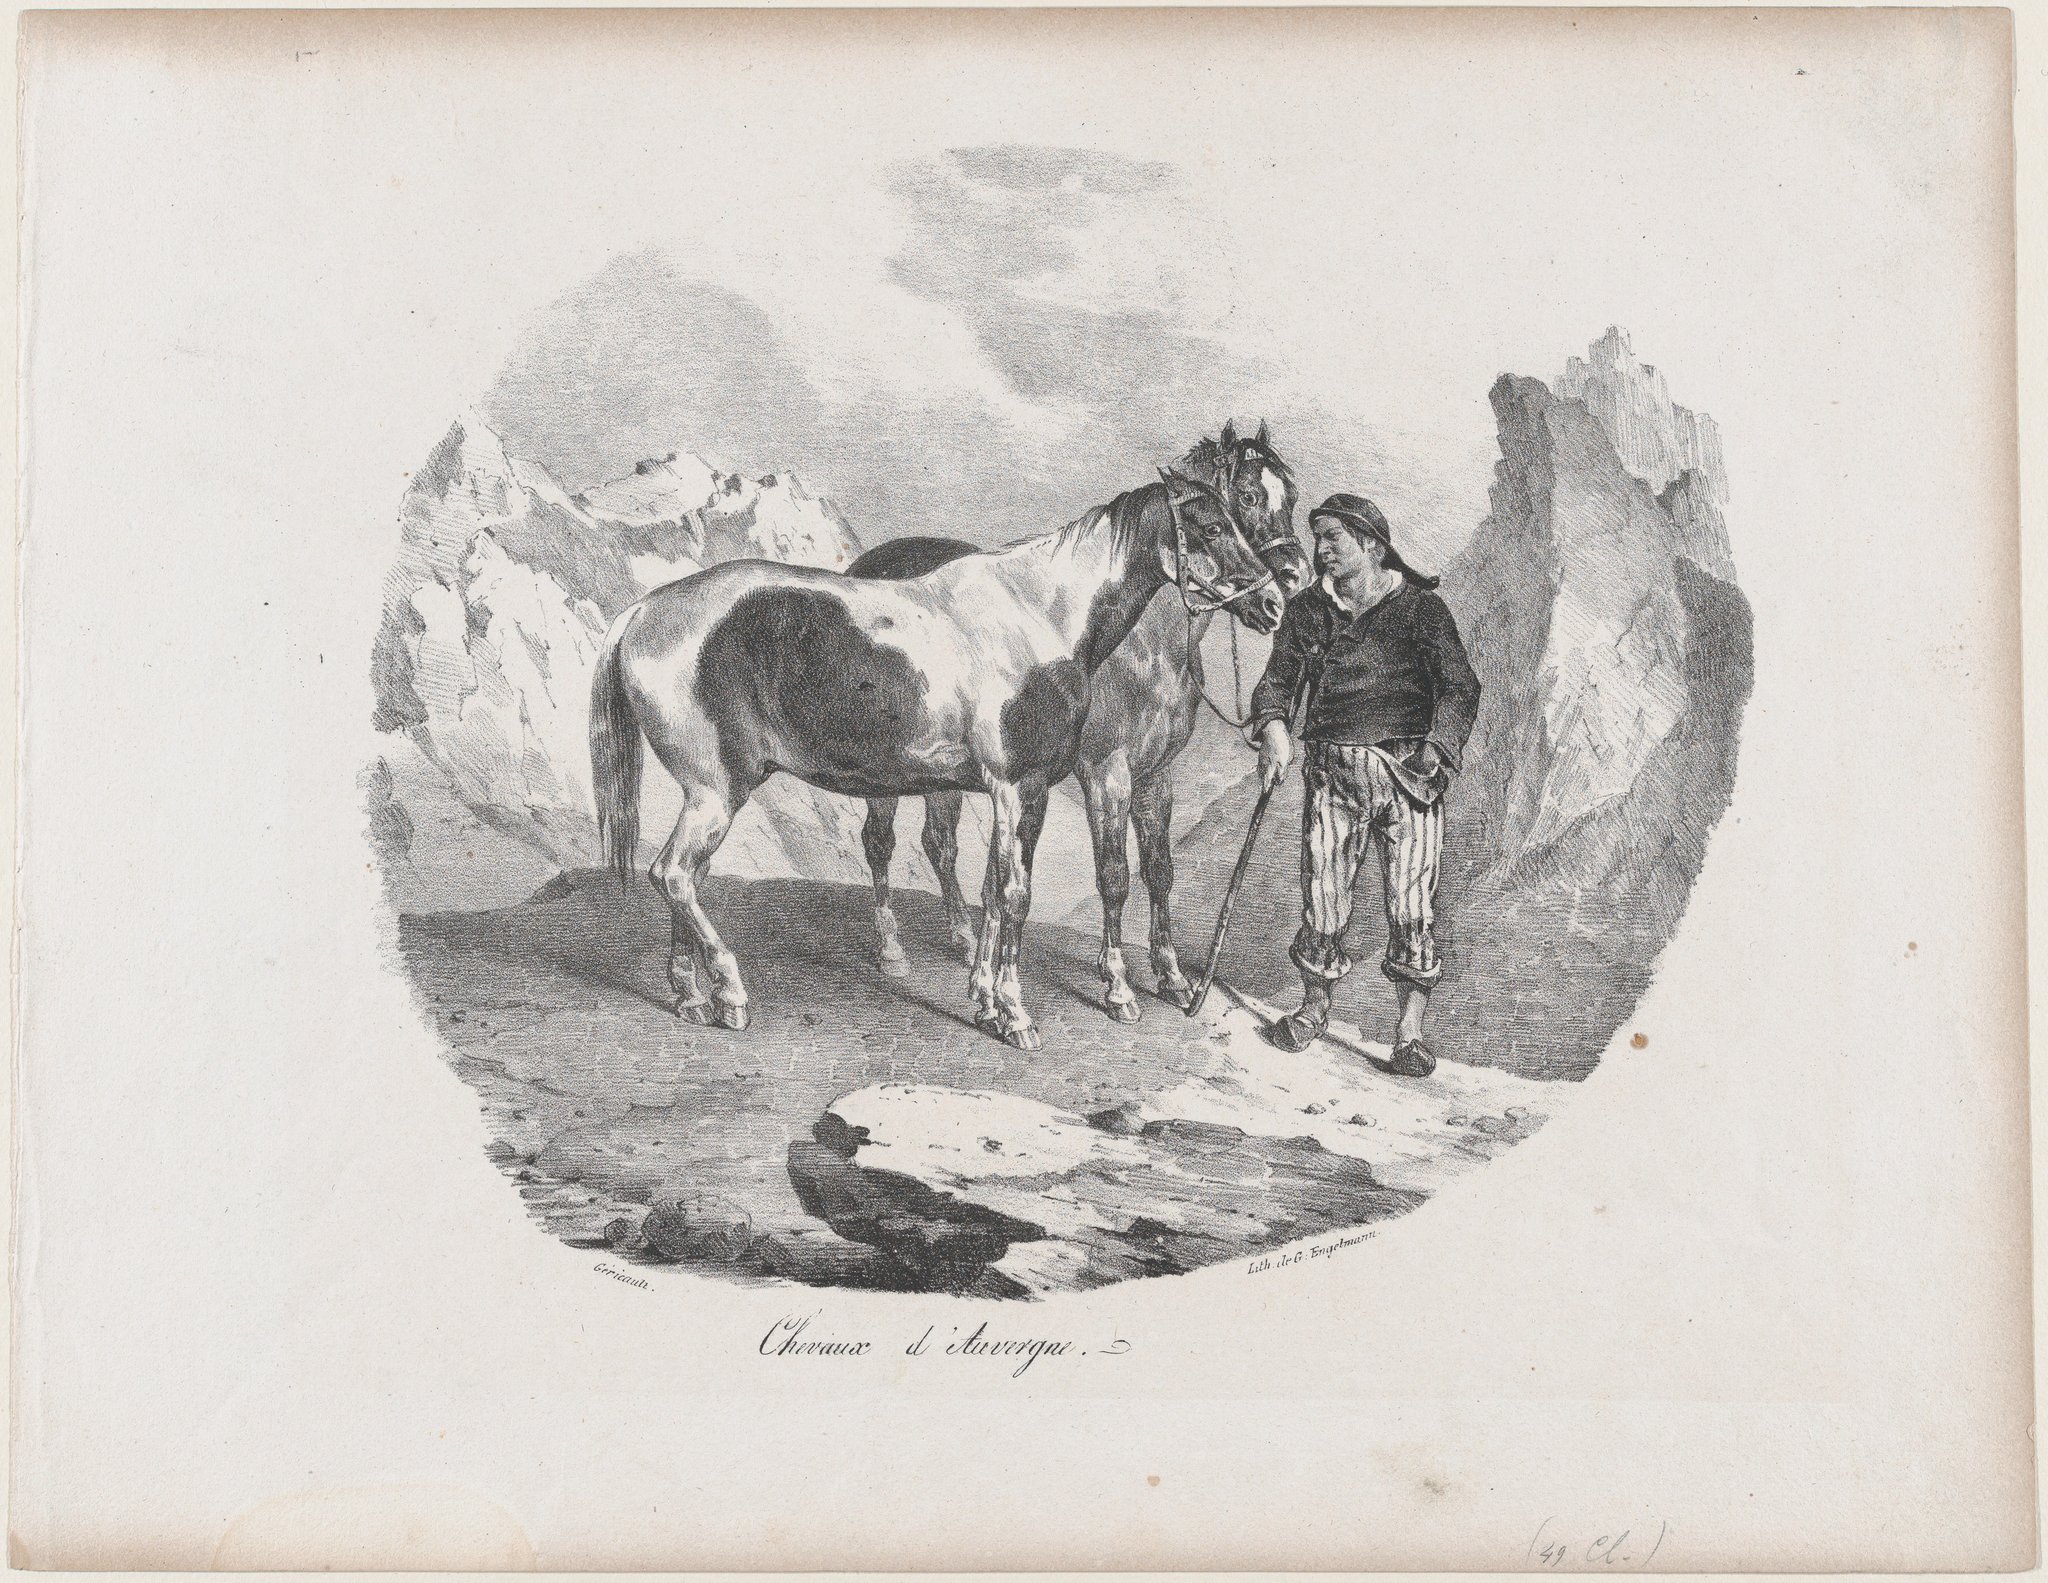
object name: print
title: Horses of Auvergne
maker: jean louis andré théodore géricault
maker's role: artist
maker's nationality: french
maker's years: 1791-1824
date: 1822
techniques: lithograph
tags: men,horses